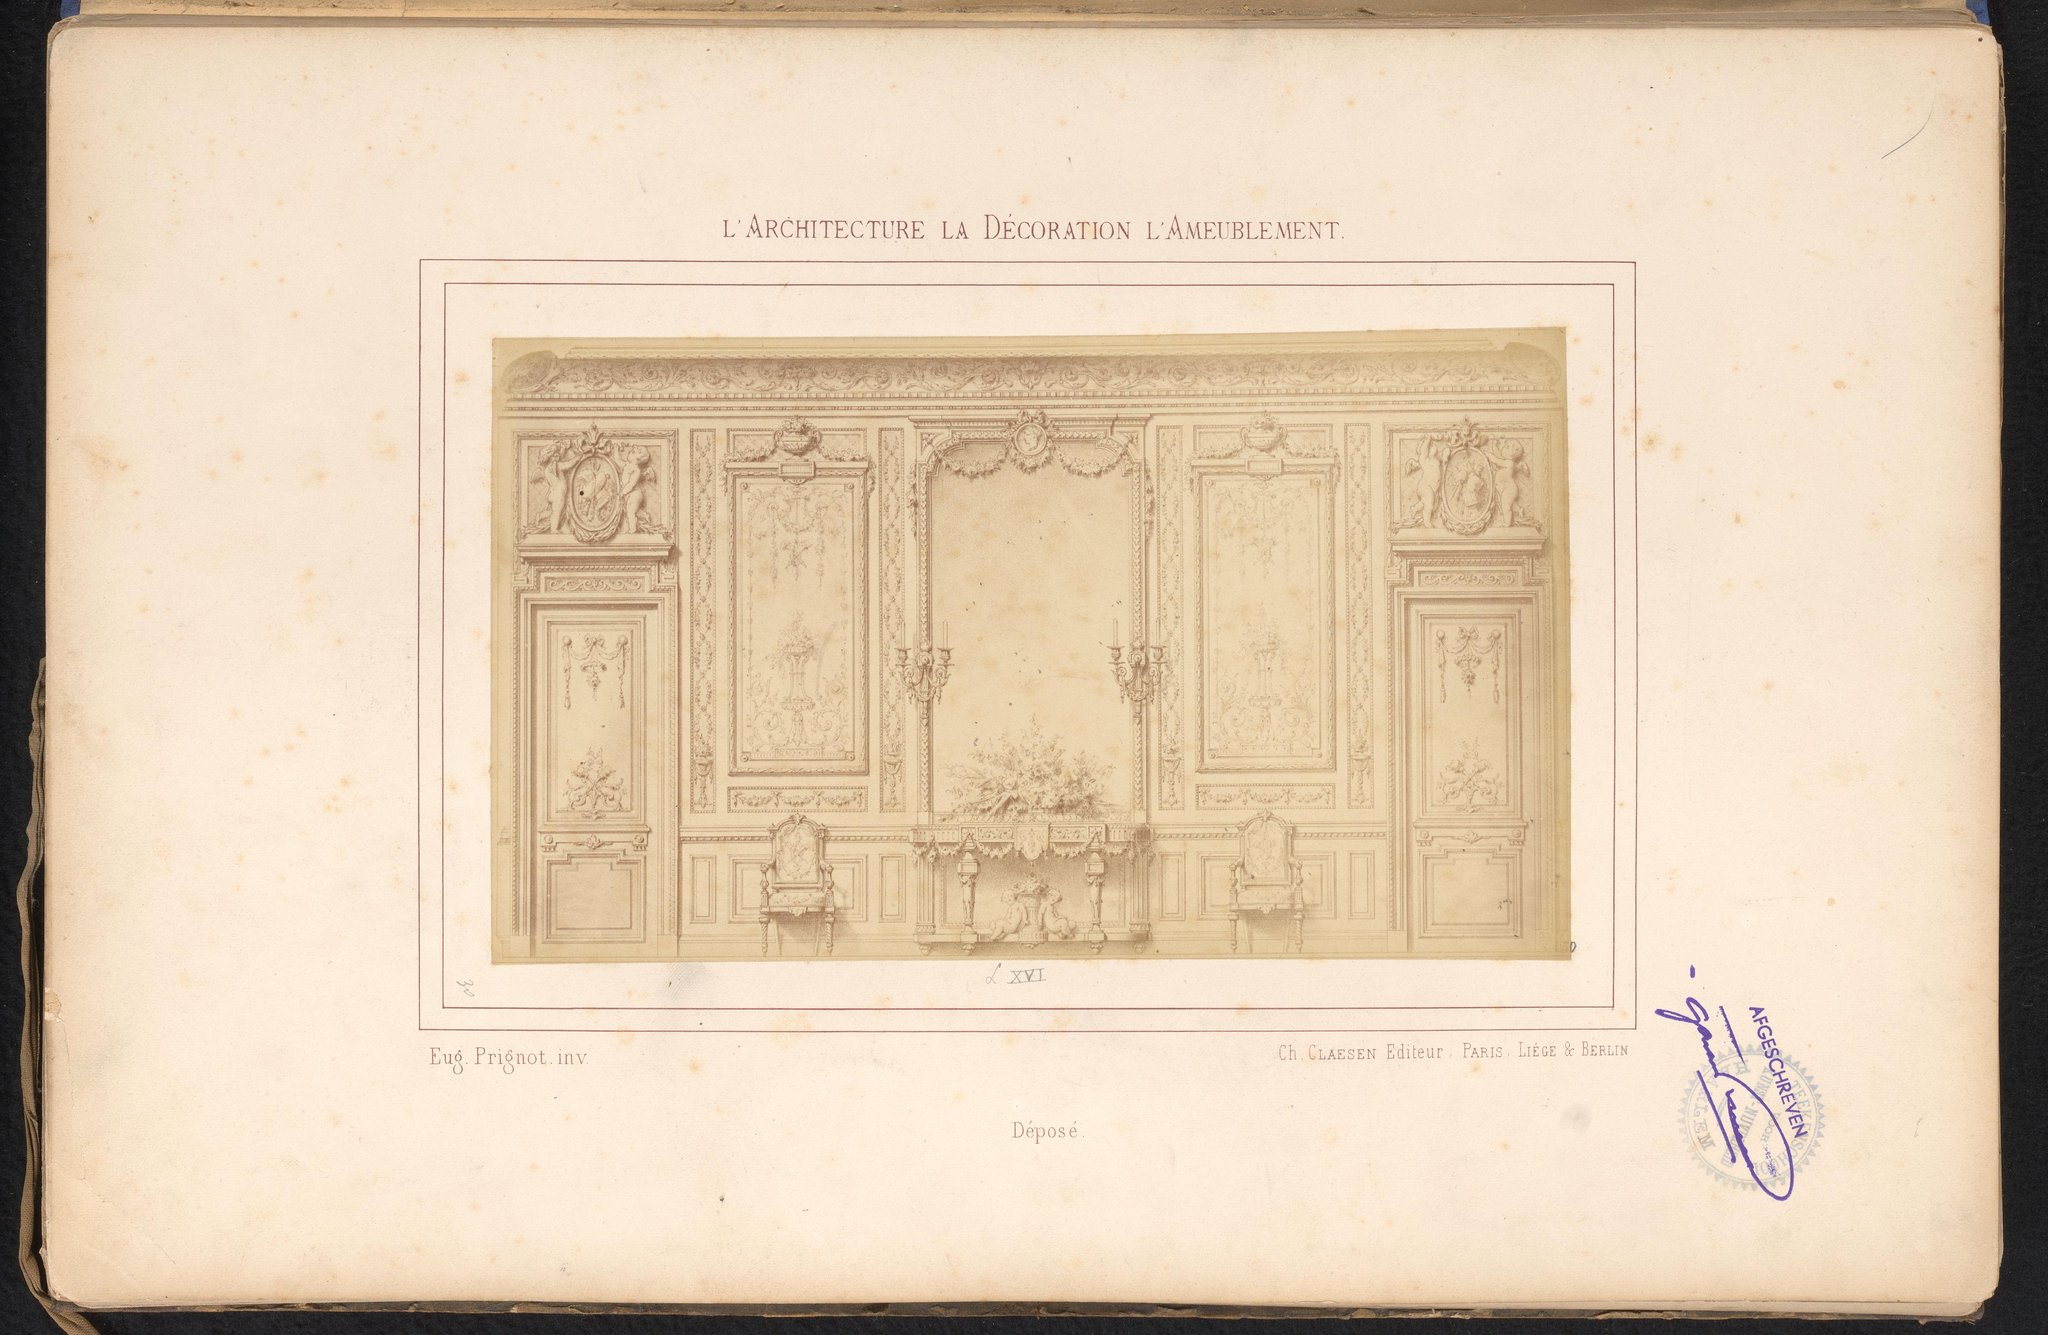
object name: reproduction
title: L'Architecture la Décoration l'Ameublement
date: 1873-1880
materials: cardboard, paper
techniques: albumen print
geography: liège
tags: mirror, door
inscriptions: number: ‘30’, stamp: ‘TEEKENSCHOOL/ VOOR/ KUNST-NIJVERHEID/ HAARLEM’, stamp: ‘AFGESCHREVEN/ [...]’, inscription: ‘Eug. Prignot. inv.’, inscription: ‘Déposé’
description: Deze foto maakt deel uit van een omslag met 61 foto's op 61 bladen.